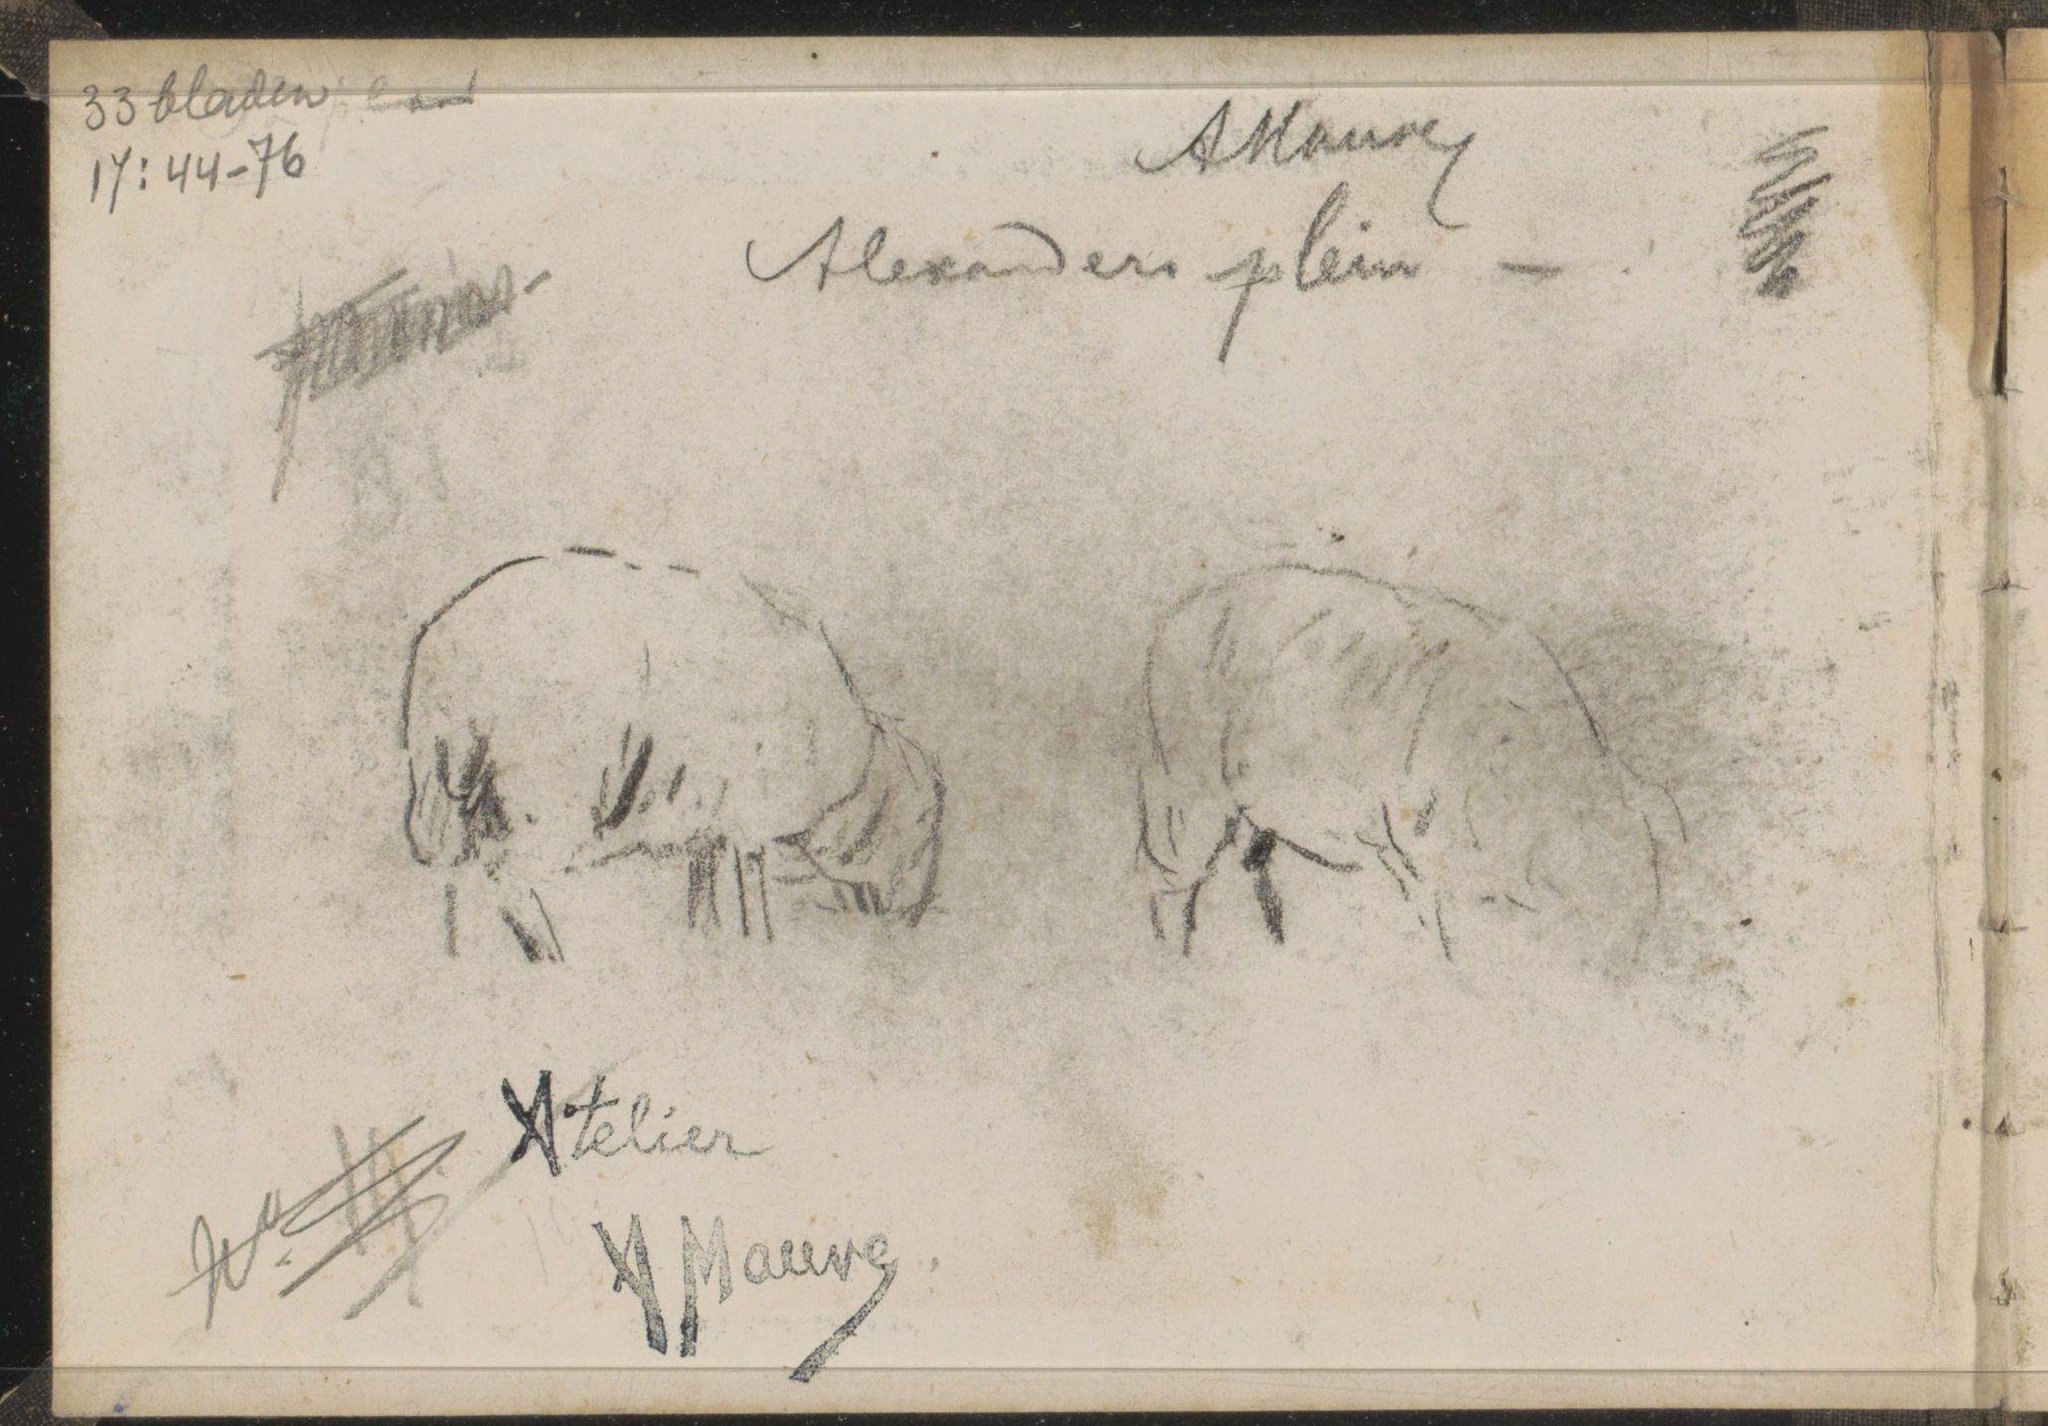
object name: endleaf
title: Twee grazende schapen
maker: anton mauve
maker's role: draughtsman, painter, print maker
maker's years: 1838-1888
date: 1848-1888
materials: chalk, paper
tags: sheep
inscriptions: signature and address: ‘A Mauve/ Alexanderplein-’, workshop stamp: ‘Atelier/ A Mauve.’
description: Voorste schutblad uit een schetsboek met 33 bladen.